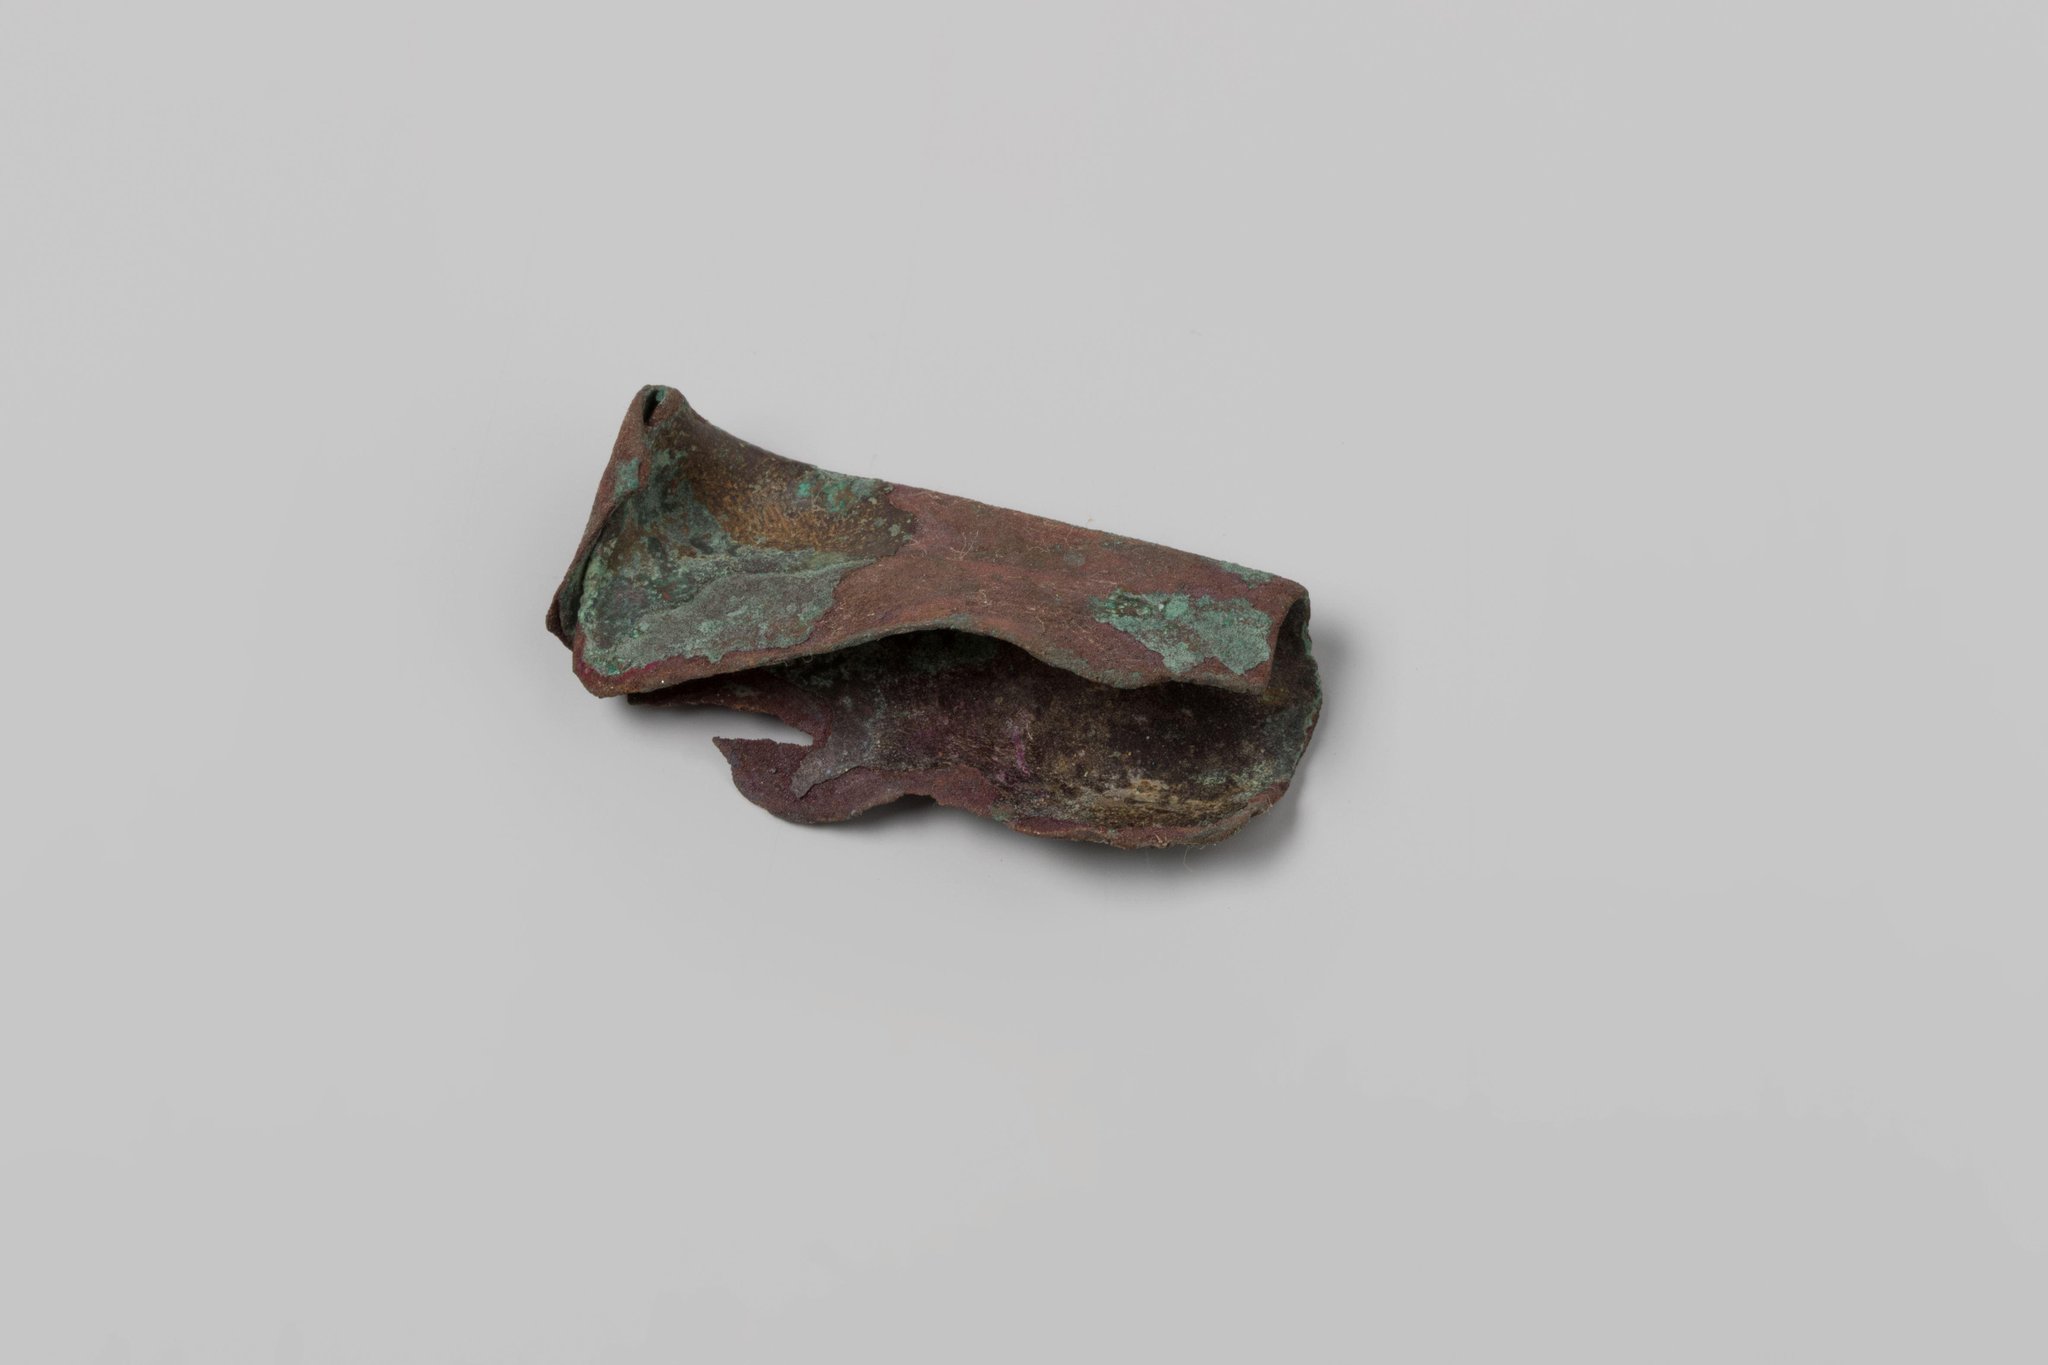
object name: fragment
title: Fragment koper uit het wrak van de Oost-Indiëvaarder Hollandia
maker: Anonymous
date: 1700-1743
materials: copper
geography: netherlands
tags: verenigde oostindische compagnie, hollandia (schip), annet